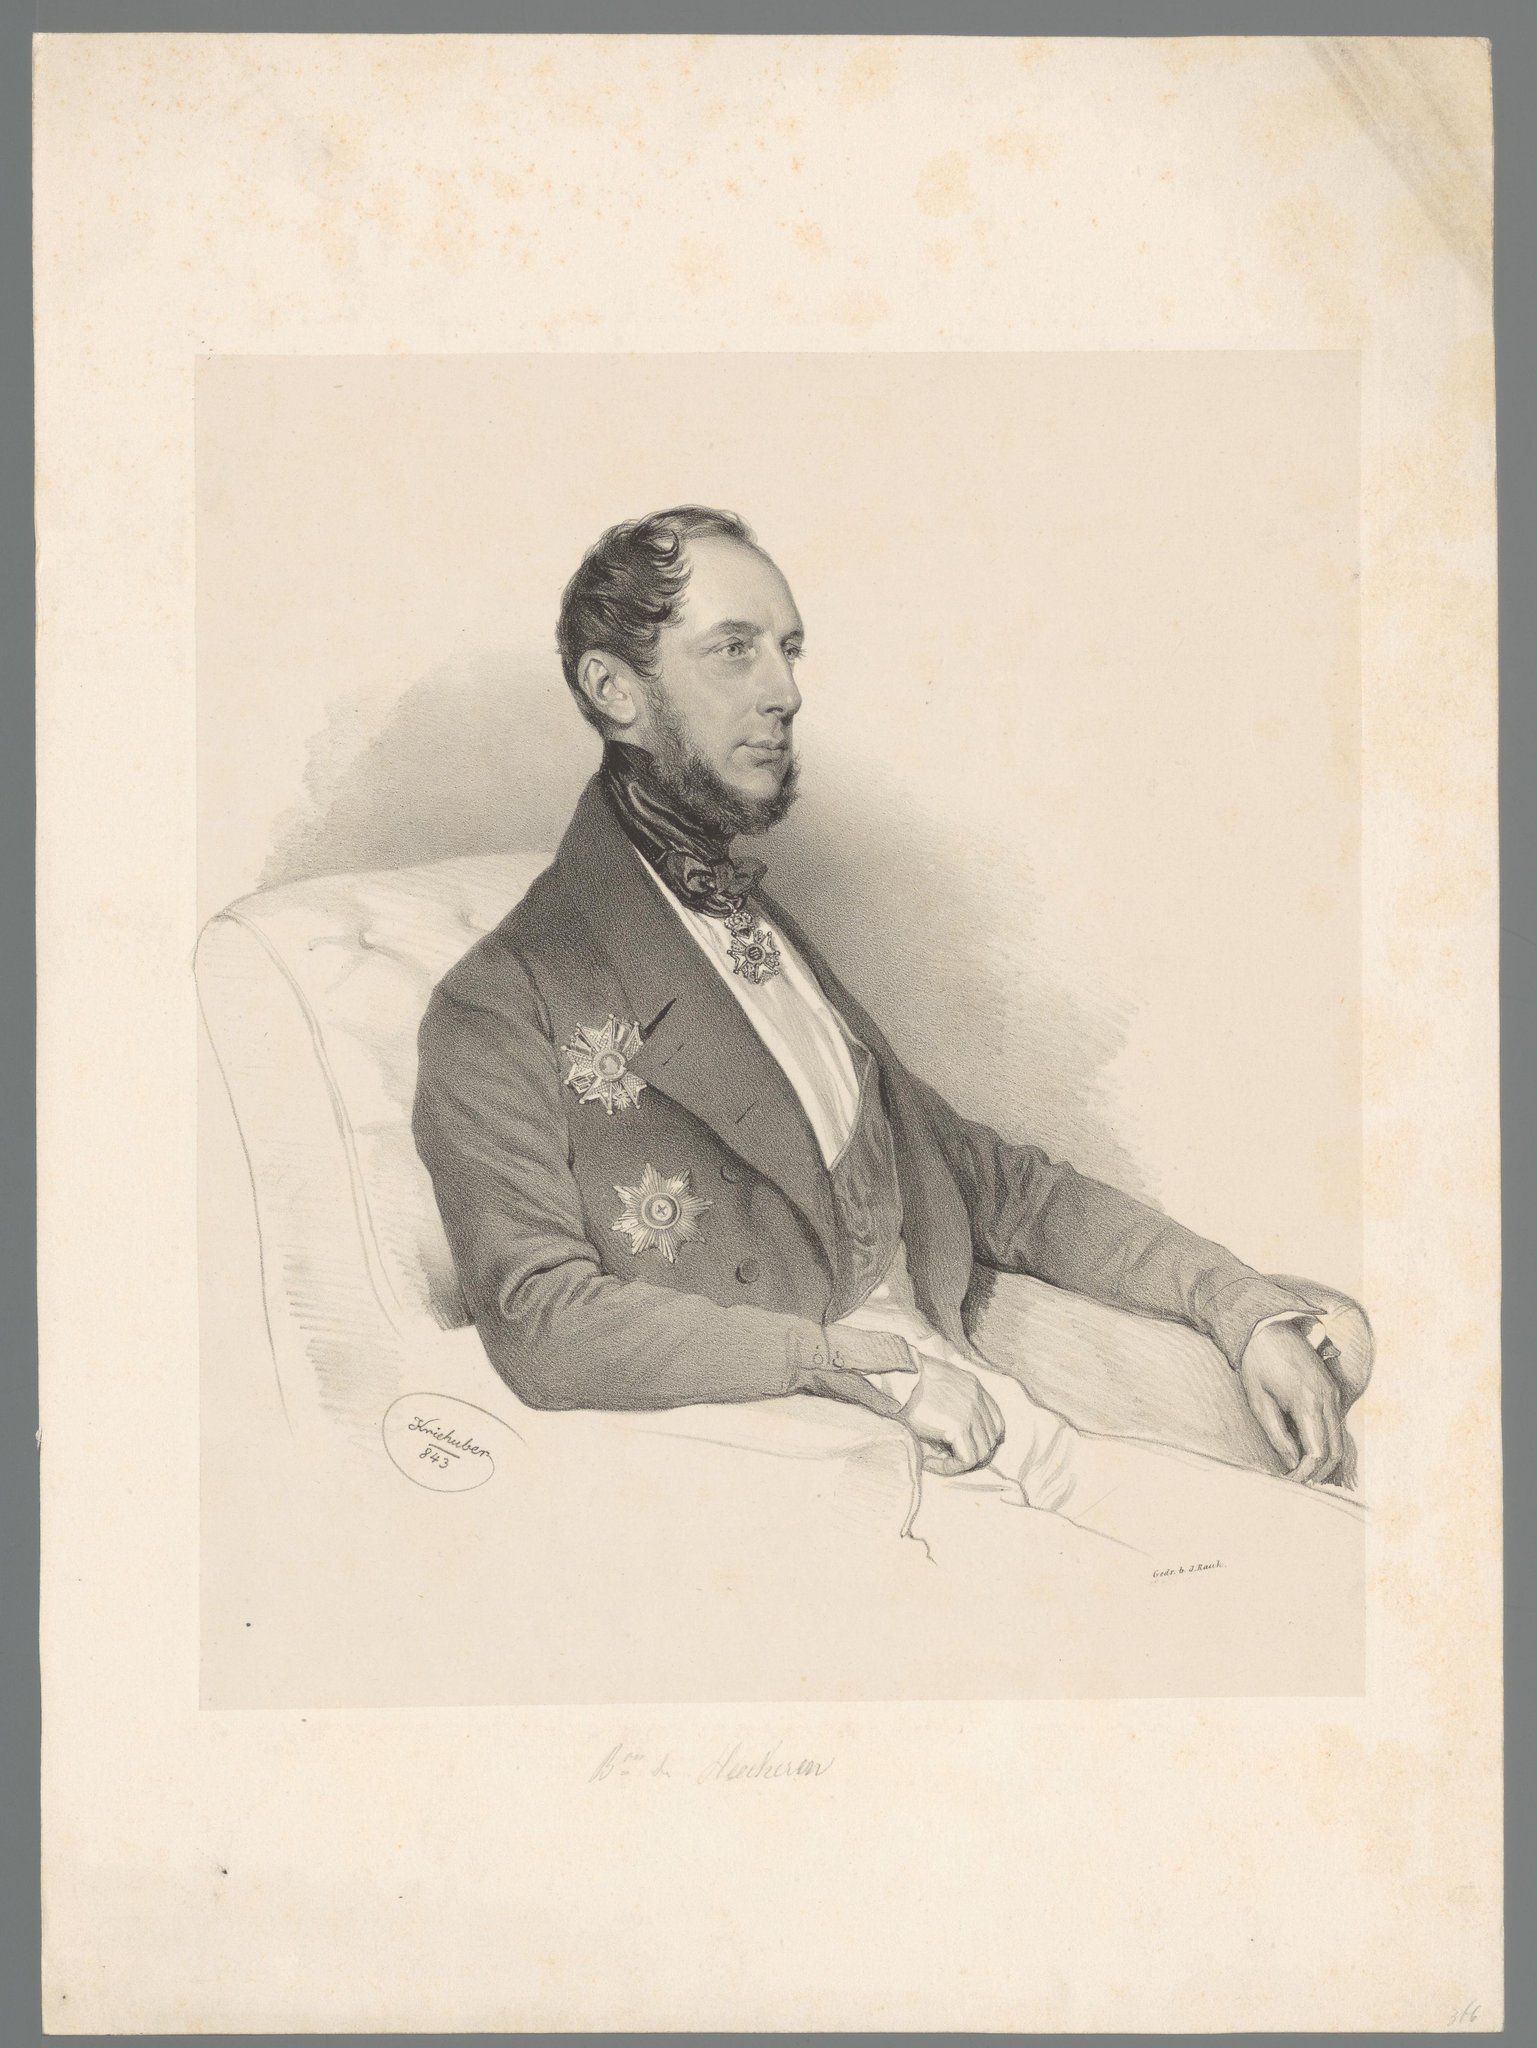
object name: print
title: Portret van Jacob baron van Heeckeren tot Enghuizen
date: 1843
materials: paper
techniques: lithograph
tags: paris, ranks in the army, historical persons, diplomacy, diplomat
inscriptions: collector's mark: Lugt 2228